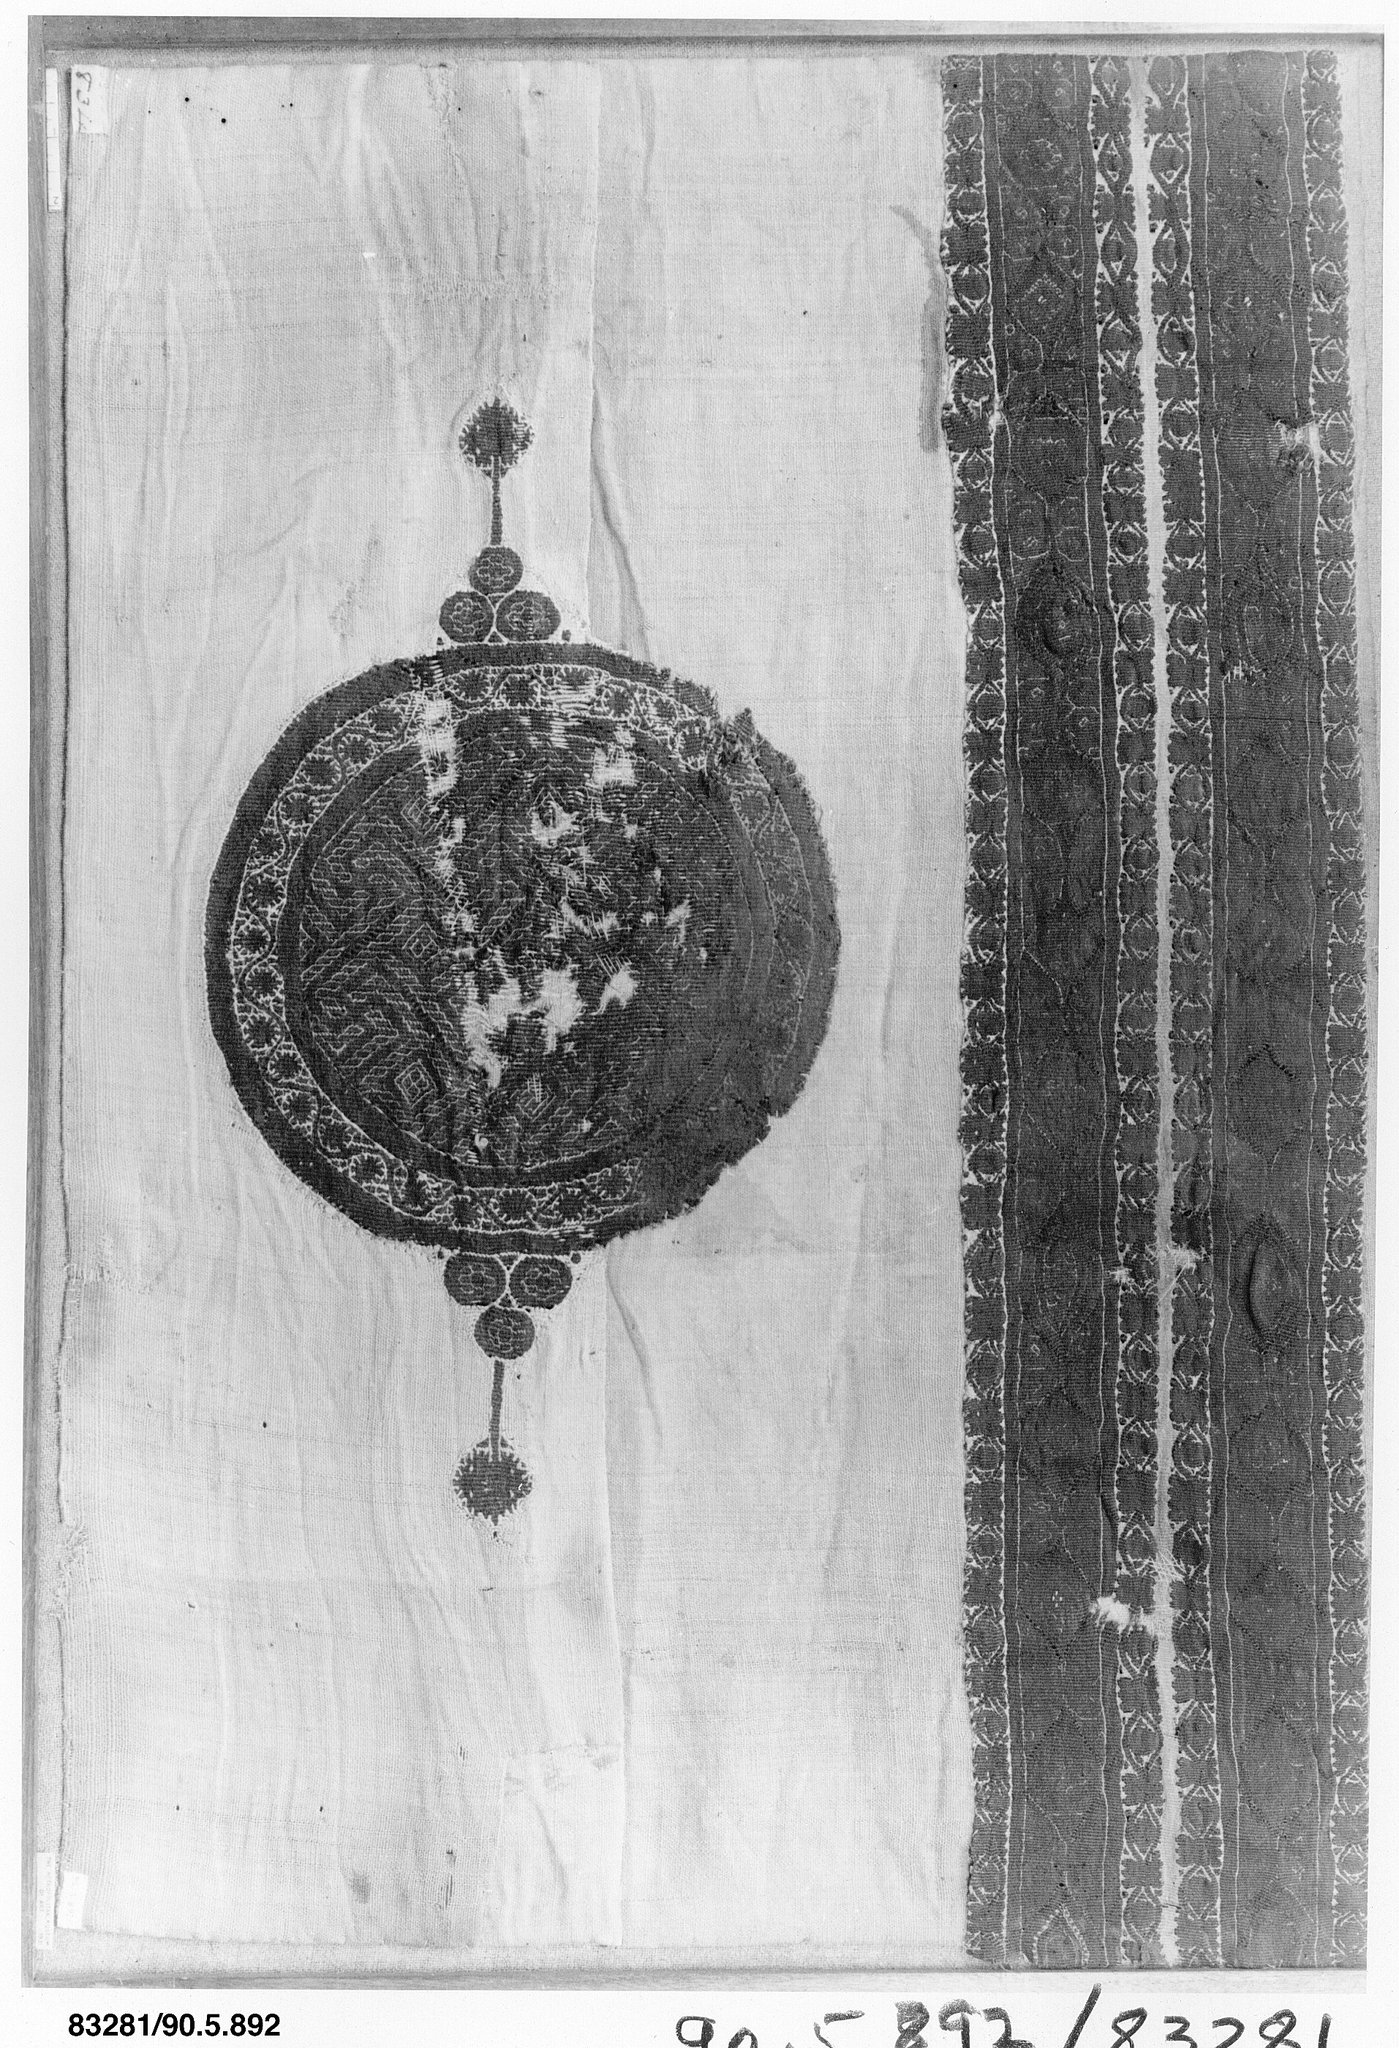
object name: textile fragment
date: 201-400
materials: linen, wool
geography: egypt